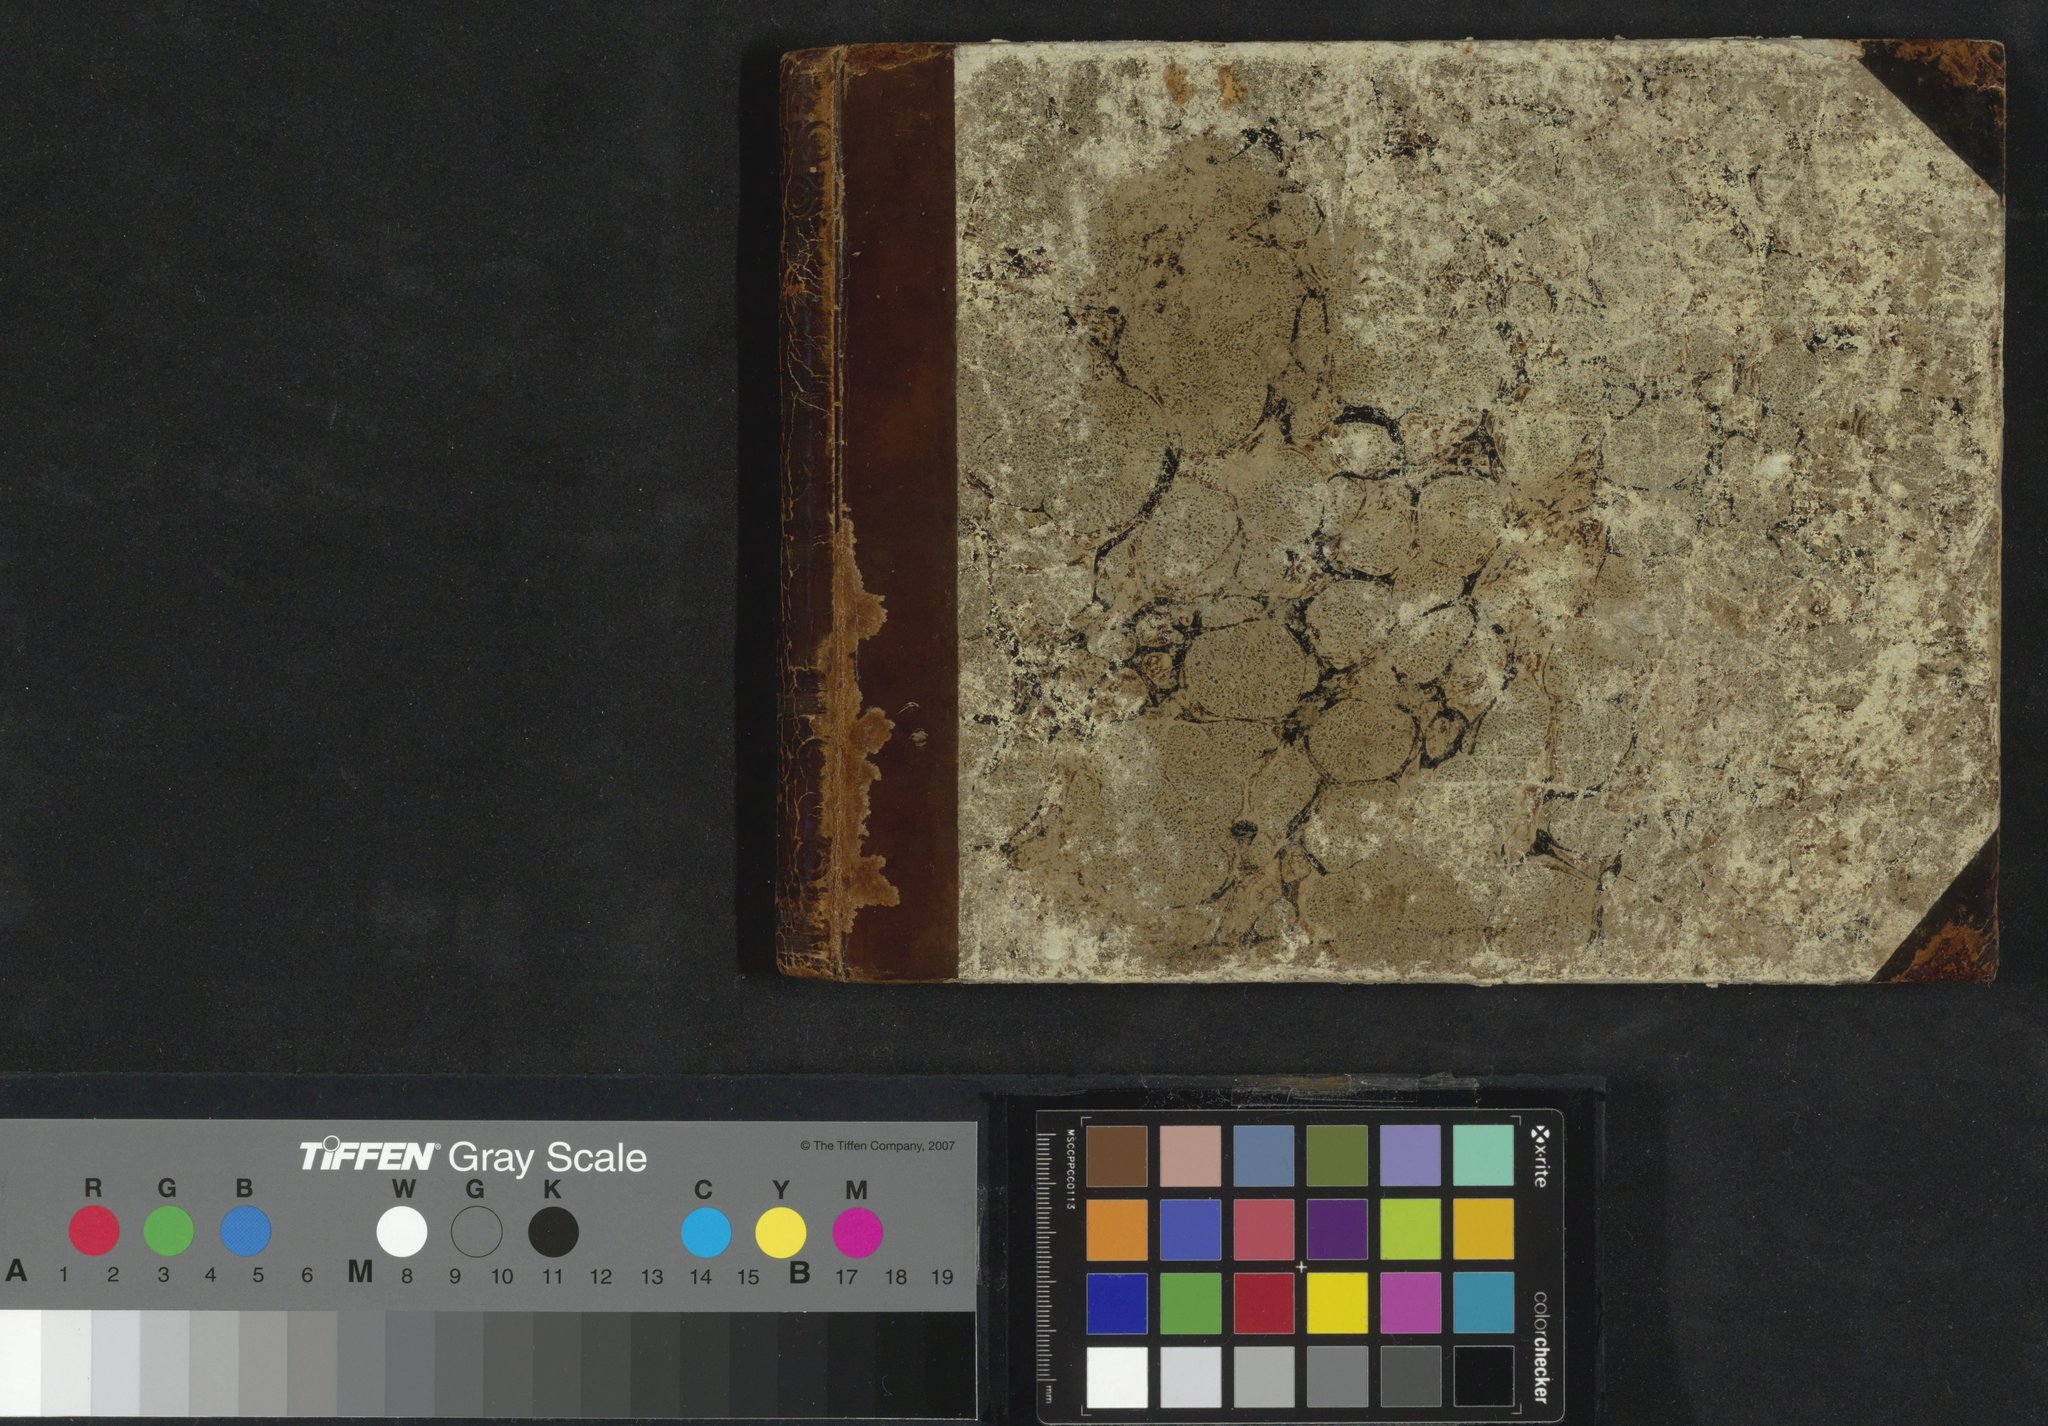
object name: sketchbook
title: Schetsboek met 58 bladen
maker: willem hendrik schmidt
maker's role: draughtsman, painter, print maker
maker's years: 1809-1849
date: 1819-1849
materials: cardboard, chalk, leather, paper, pencil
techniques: stumping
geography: groenendijk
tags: historical costume, interior of the house, picture, painting, architecture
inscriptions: number: ‘210’, collector's mark: Lugt 2228a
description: Schetsboek bestaande uit 58 bladen met architectuur, figuren, historisch kostuum, interieurs met figuren, kopieën naar schilderijen en compositiestudies. Tussen het voorste schutblad en blad 1 recto zit een visitekaartje van de schilder 'J.M. Ranftl, Wieden, Hauptstrasse Waaggasse No. 501' met verso in potlood de annotatie '[...] 31'.